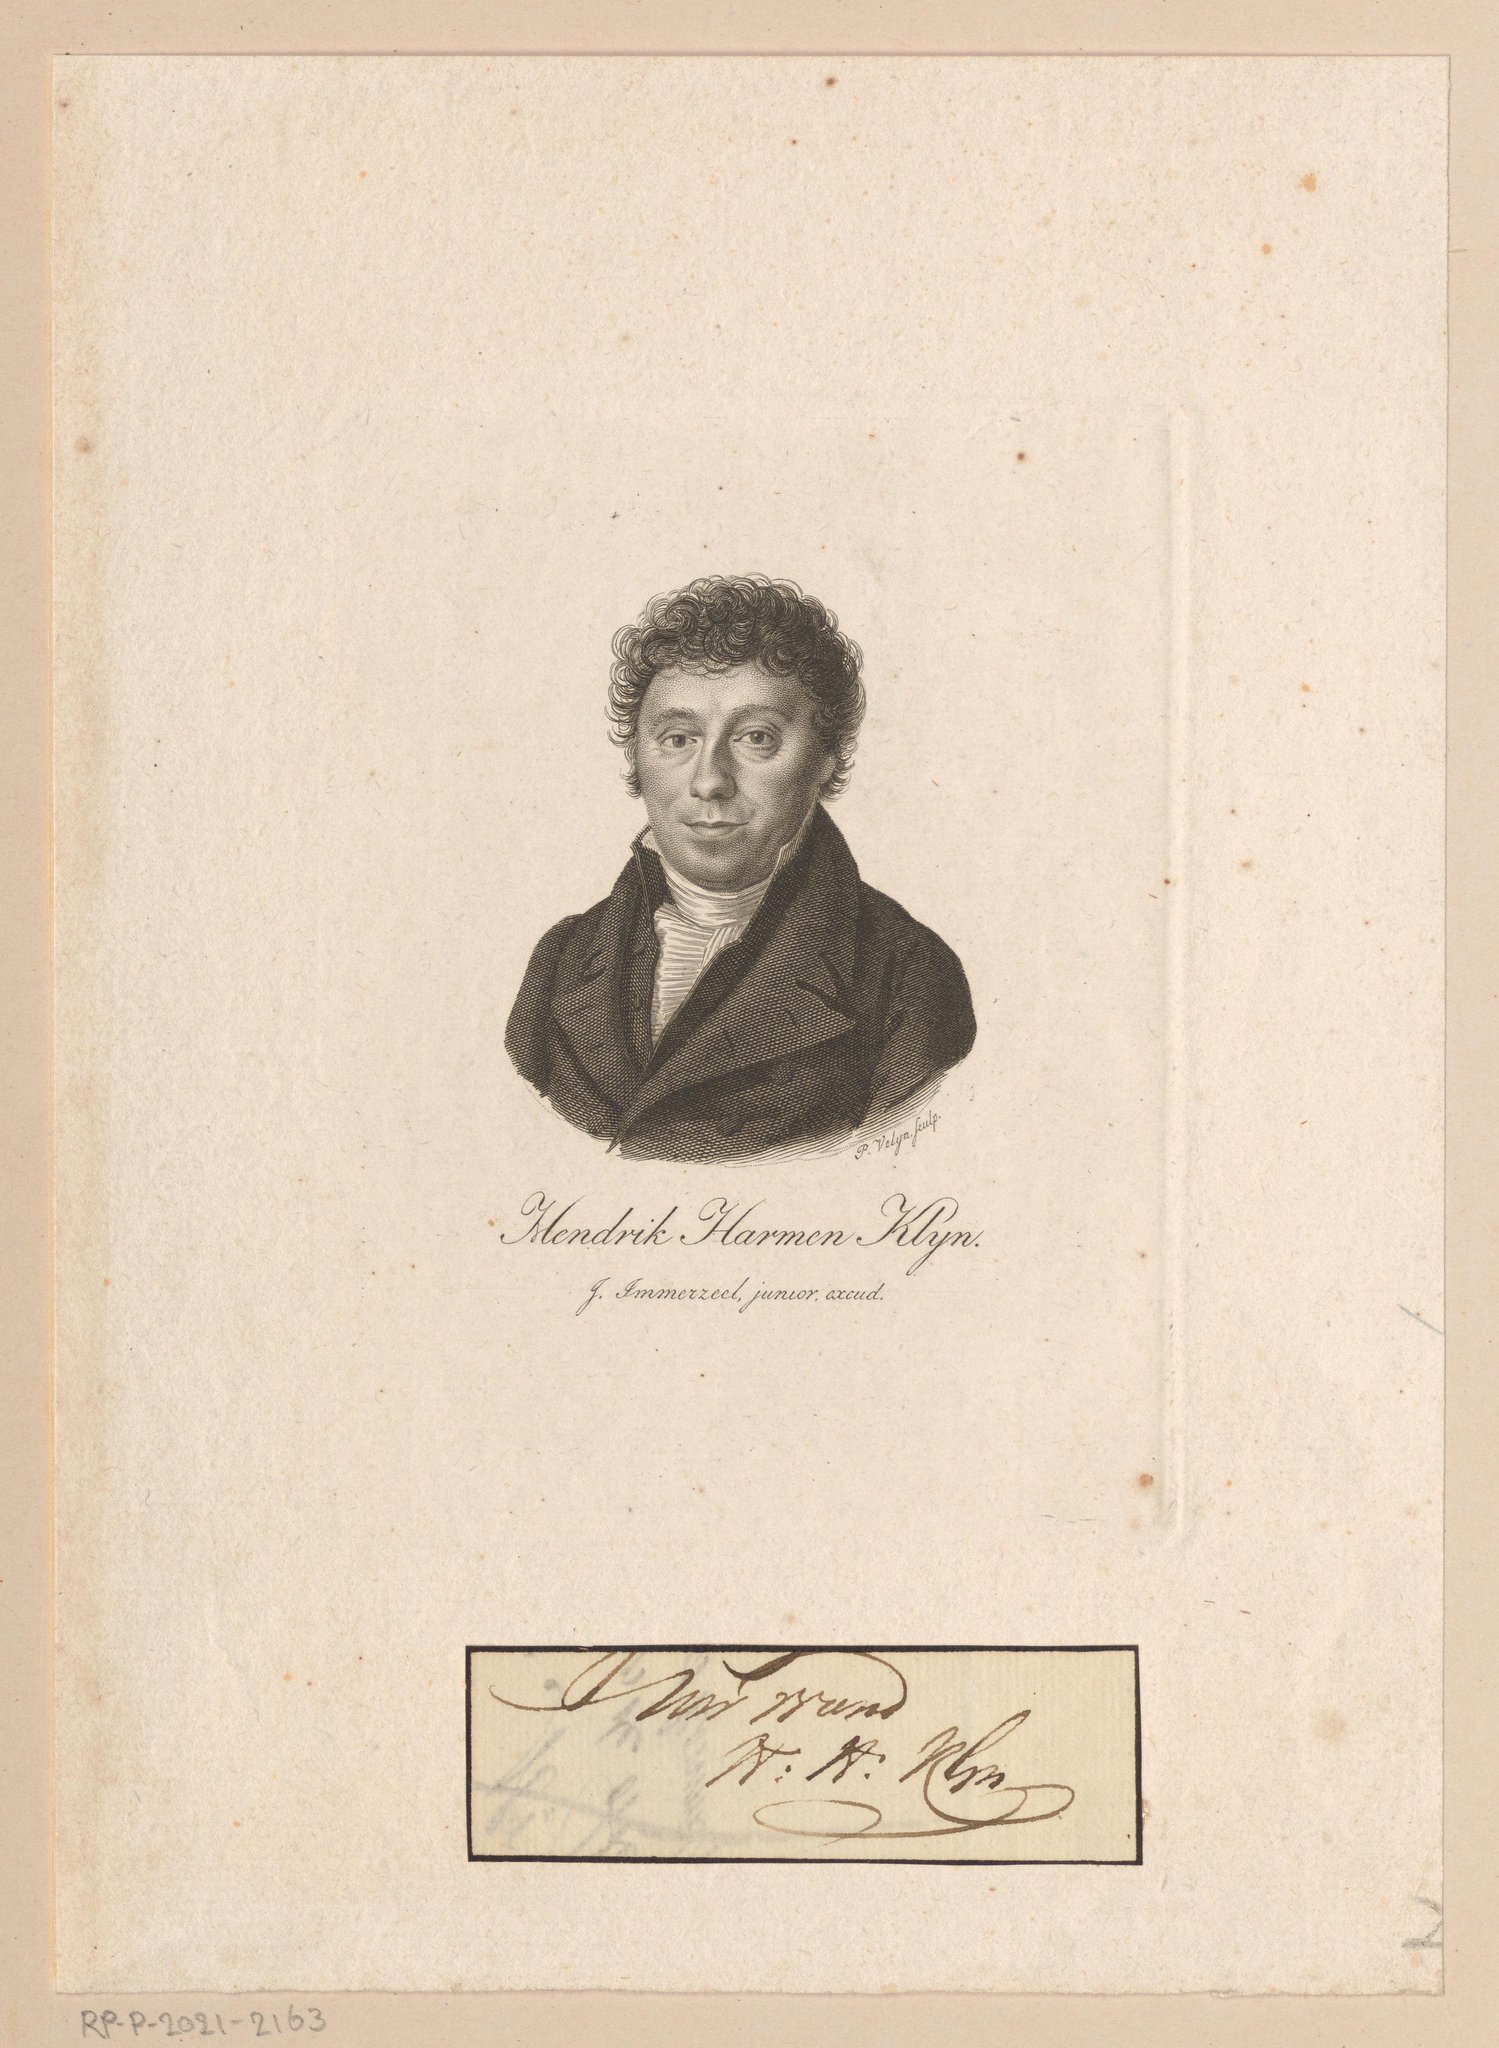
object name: print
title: Portret van Hendrik Harmen Klijn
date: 1811-1841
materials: paper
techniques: engraving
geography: the hague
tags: hendrik harmen klijn, historical persons